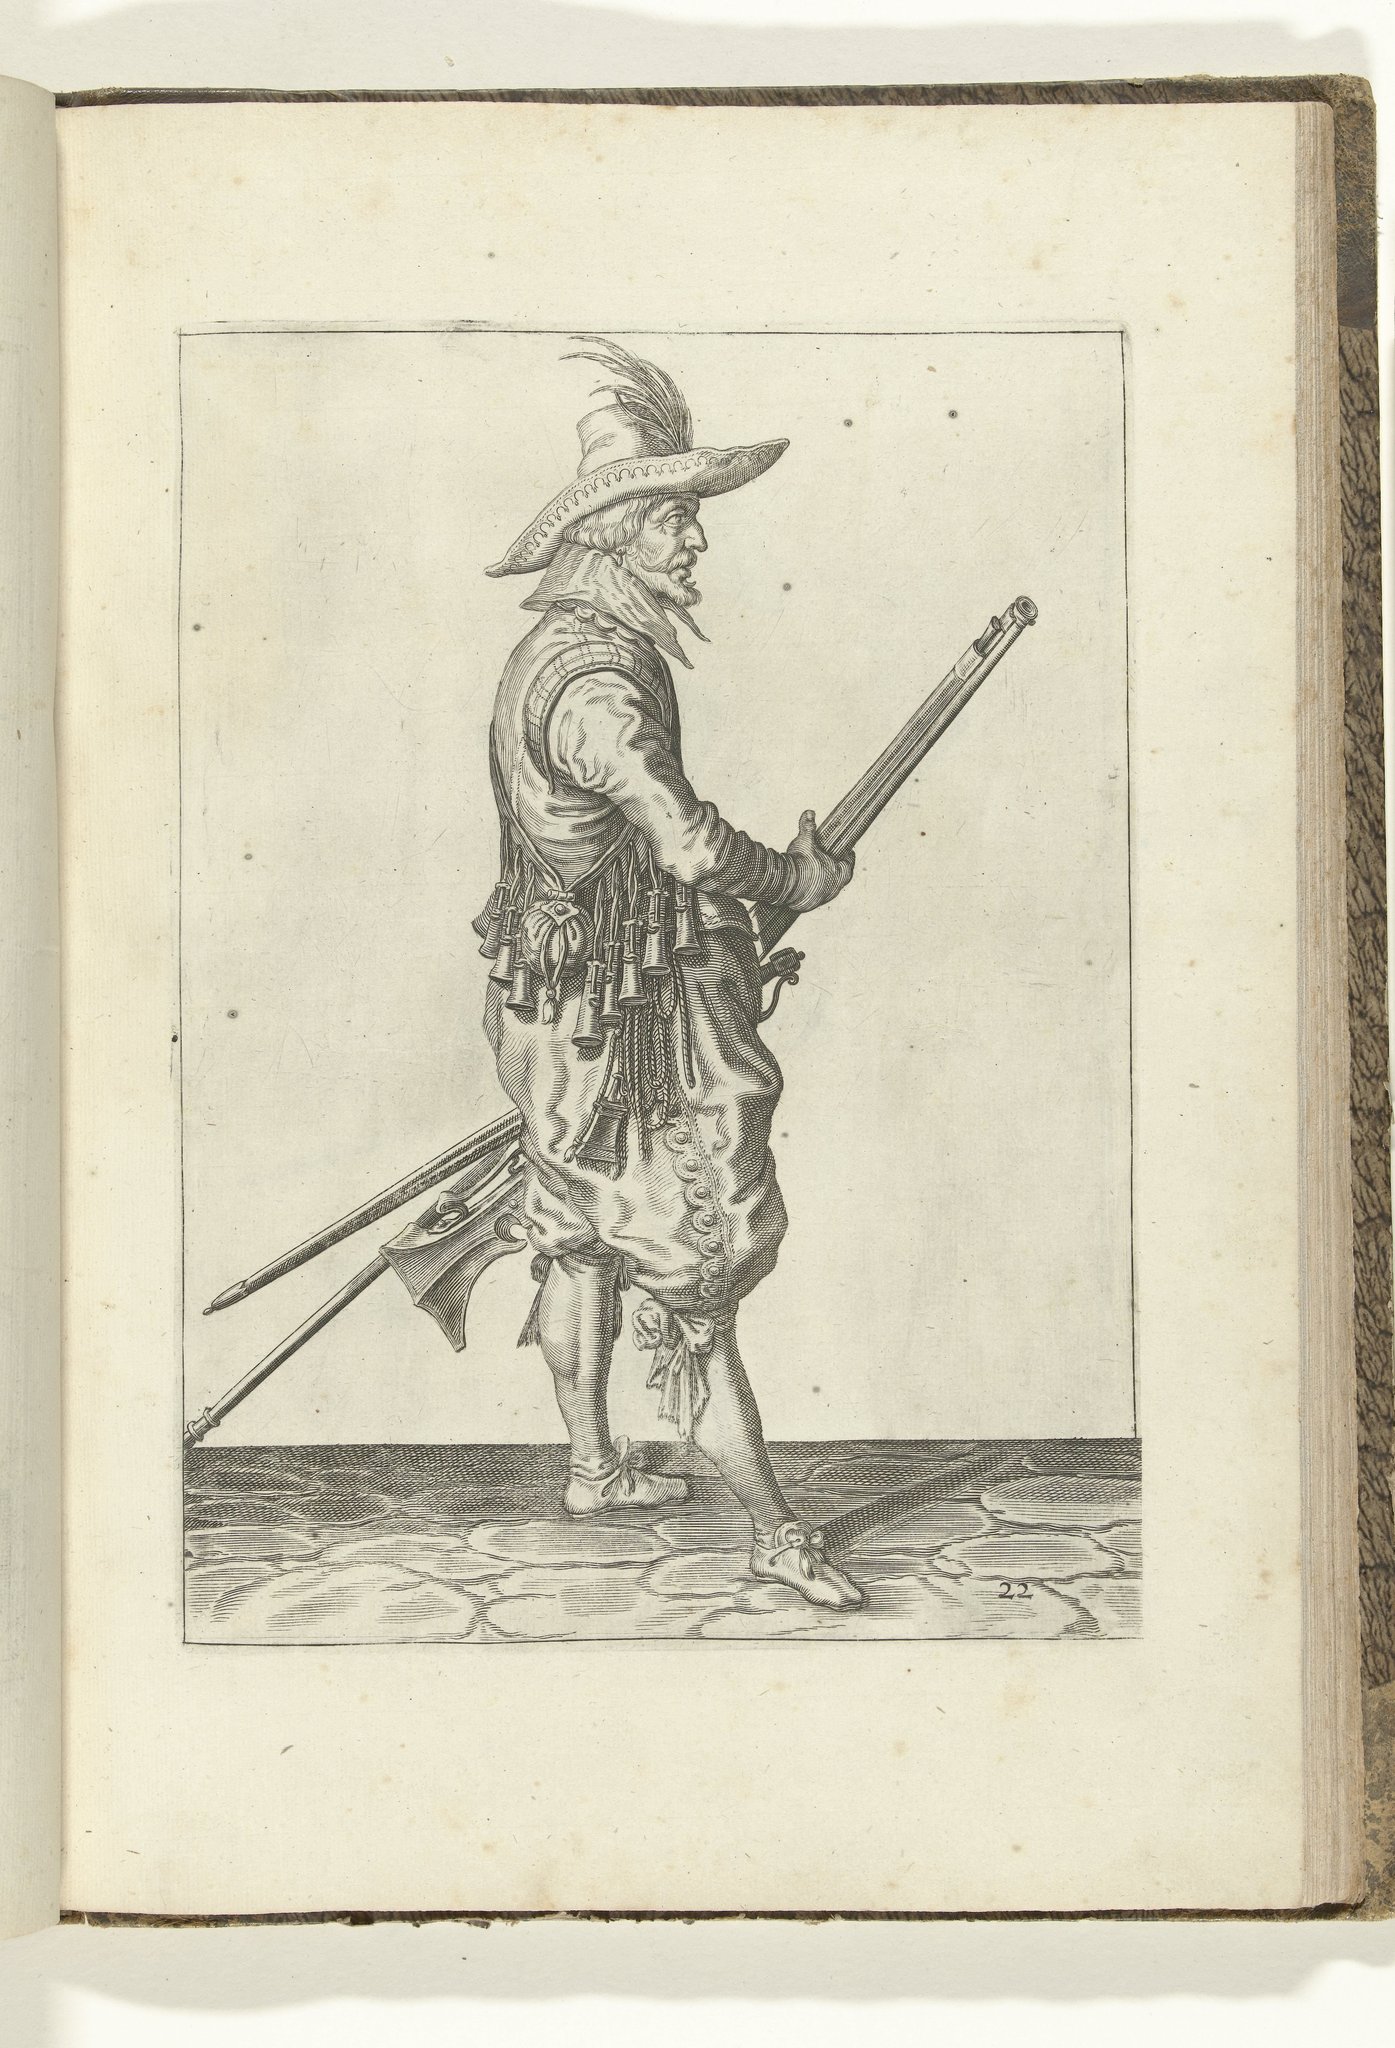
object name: print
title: Soldaat die zijn musket met beide handen bij zijn linkerdijbeen vasthoudt (nr. 22), ca. 1600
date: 1597-1608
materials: paper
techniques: engraving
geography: amsterdam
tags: maurice (prince of orange), handling of weapons ~ military training, weapons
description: Een soldaat, ten voeten uit, naar rechts, die met beide handen bij zijn linkerdijbeen een musket (een bepaald type vuurwapen) vasthoudt (nr. 22), ca. 1600. Plaat 22 in de instructies voor het hanteren van het musket: Brief enseignement, sur les pourtraitz figurez, touchant le droit maniement du Mousquet. Onderdeel van de illustraties in een Franse editie van J. de Gheyns Wapenhandelinghe: J. de Gheyn, Maniement d'armes, d'arquebuses, mousquetz et piques : en conformité de l'ordre de Mour le Prince Maurice, Prince d'Orange, Amsterdam 1608. Krijgswezen rond 1600.